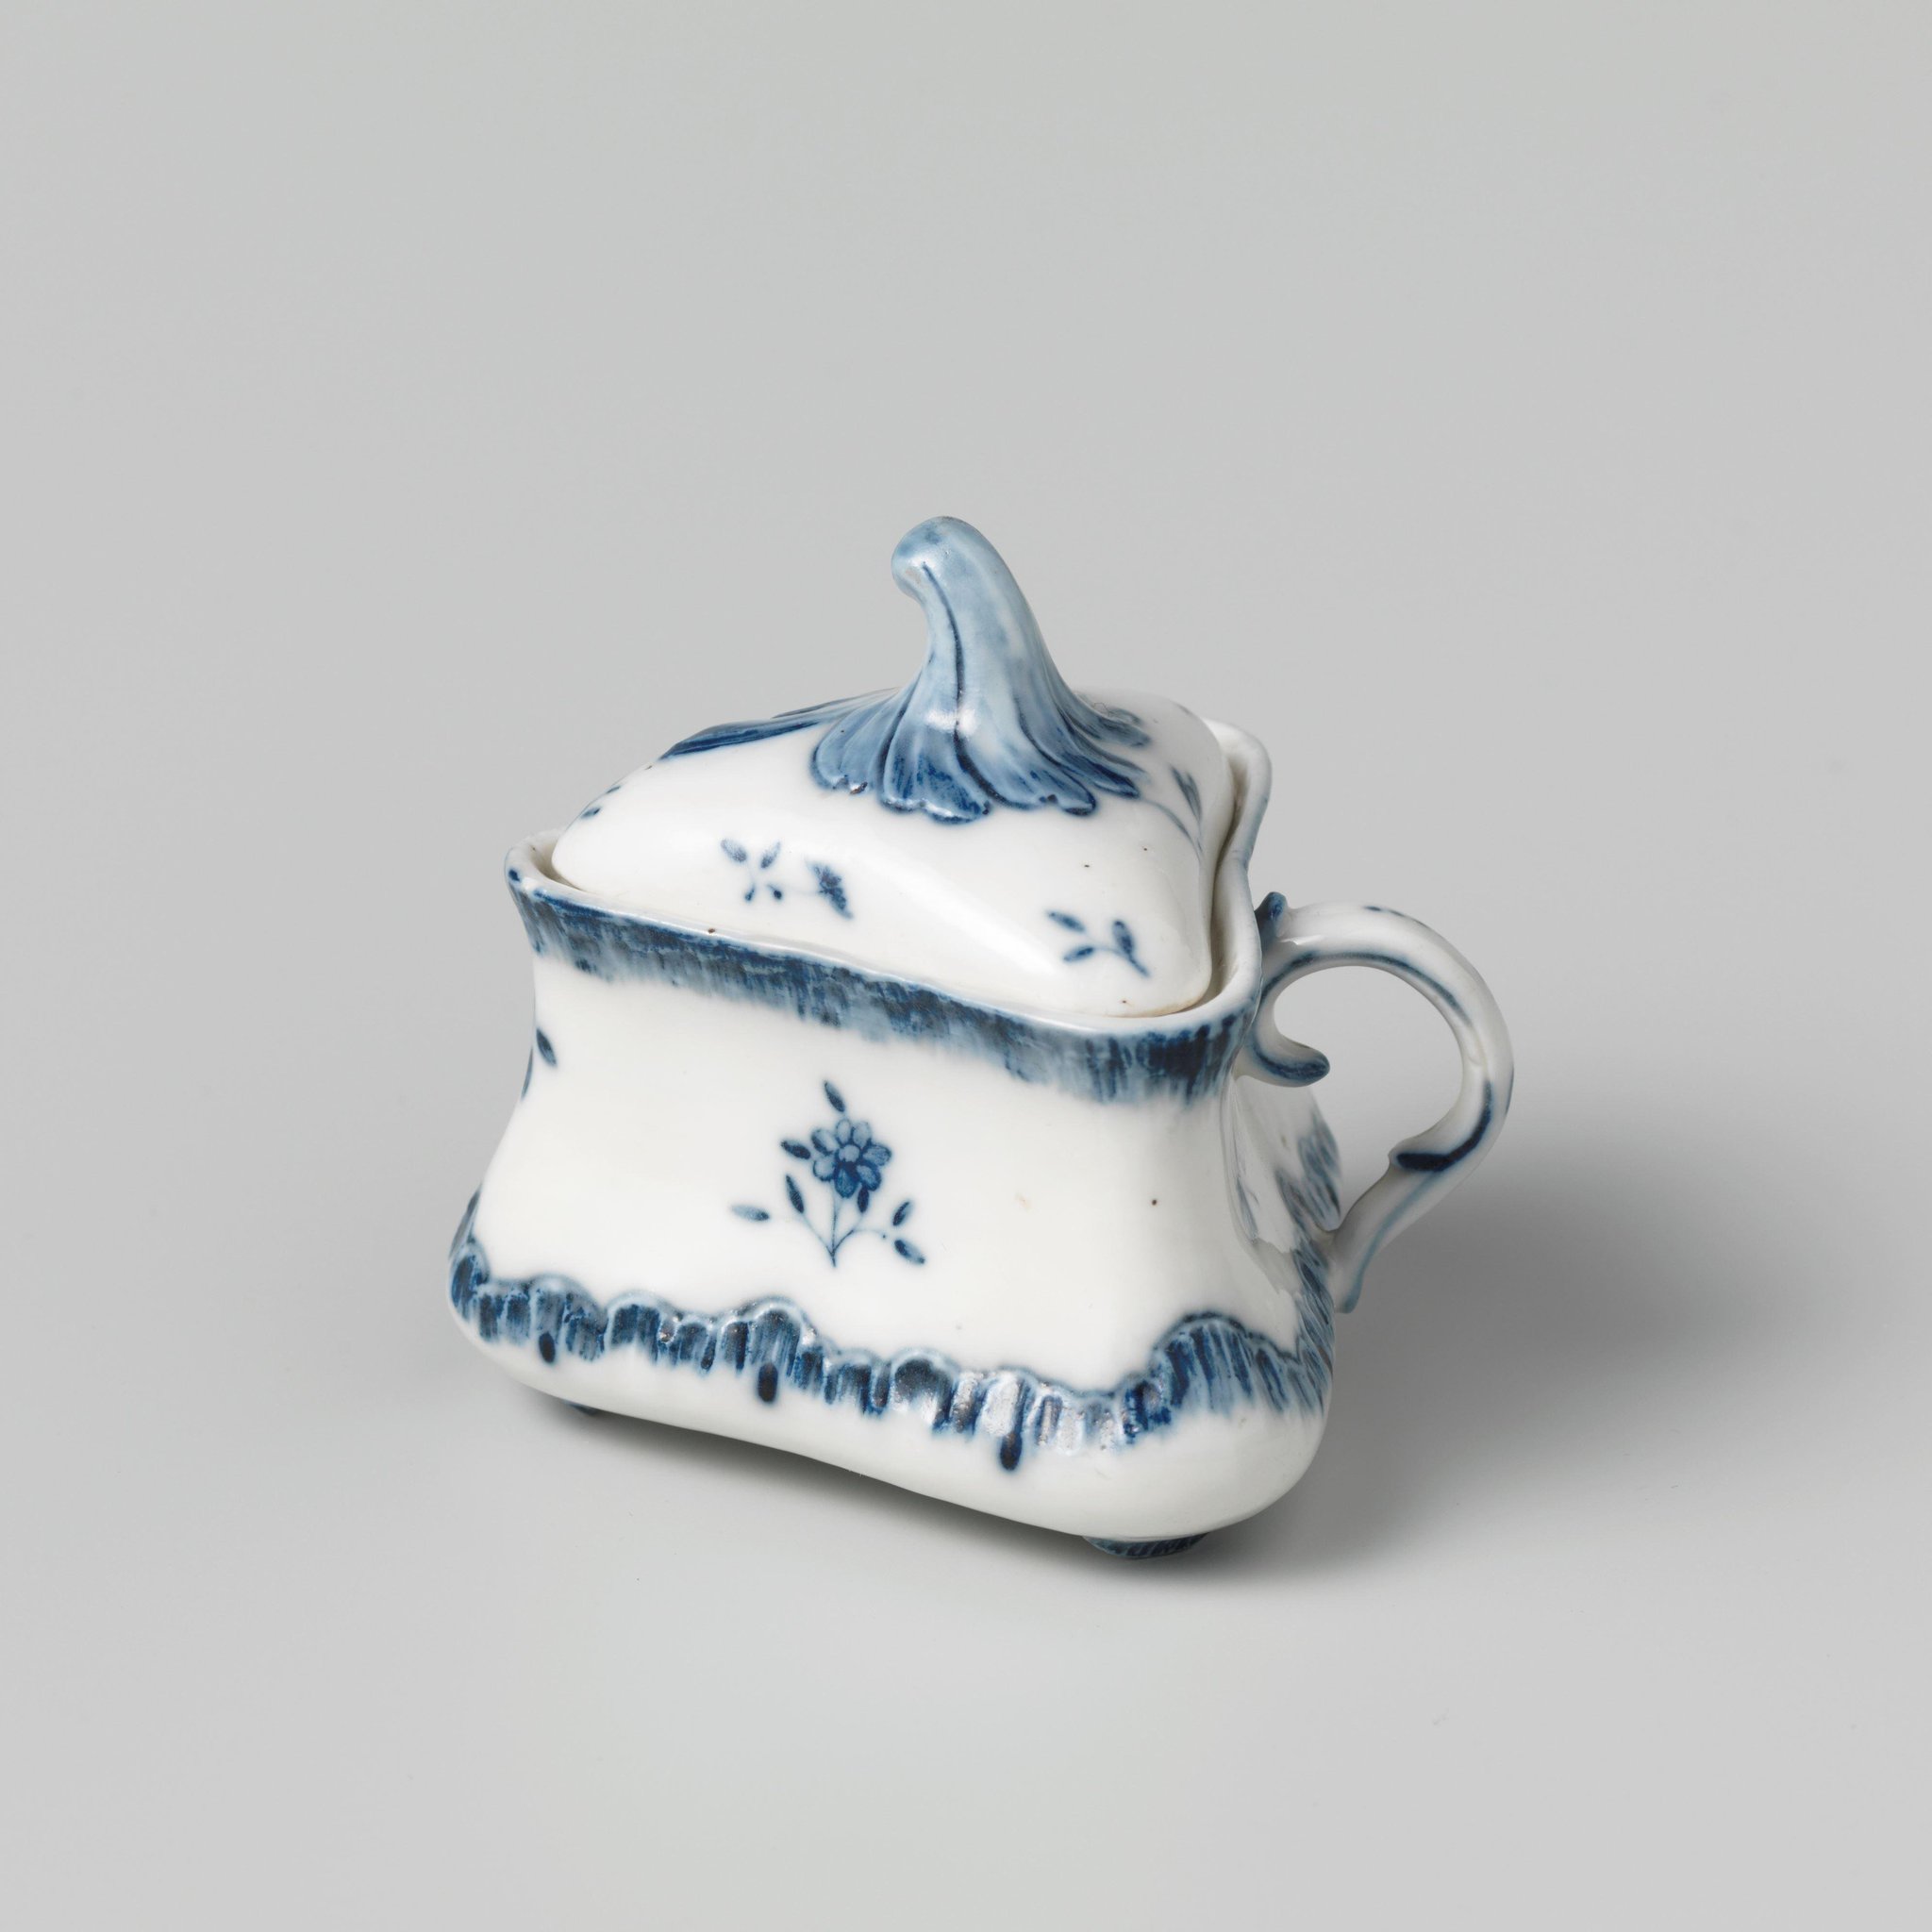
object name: roompot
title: Roompot, beschilderd met strooibloemen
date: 1774-1778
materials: porcelain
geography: loosdrecht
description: Cream pot. Porcelain, decorated in underglaze blue. Loosdrecht, c. 1774 - 1776. Factory of Joannes de Mol.